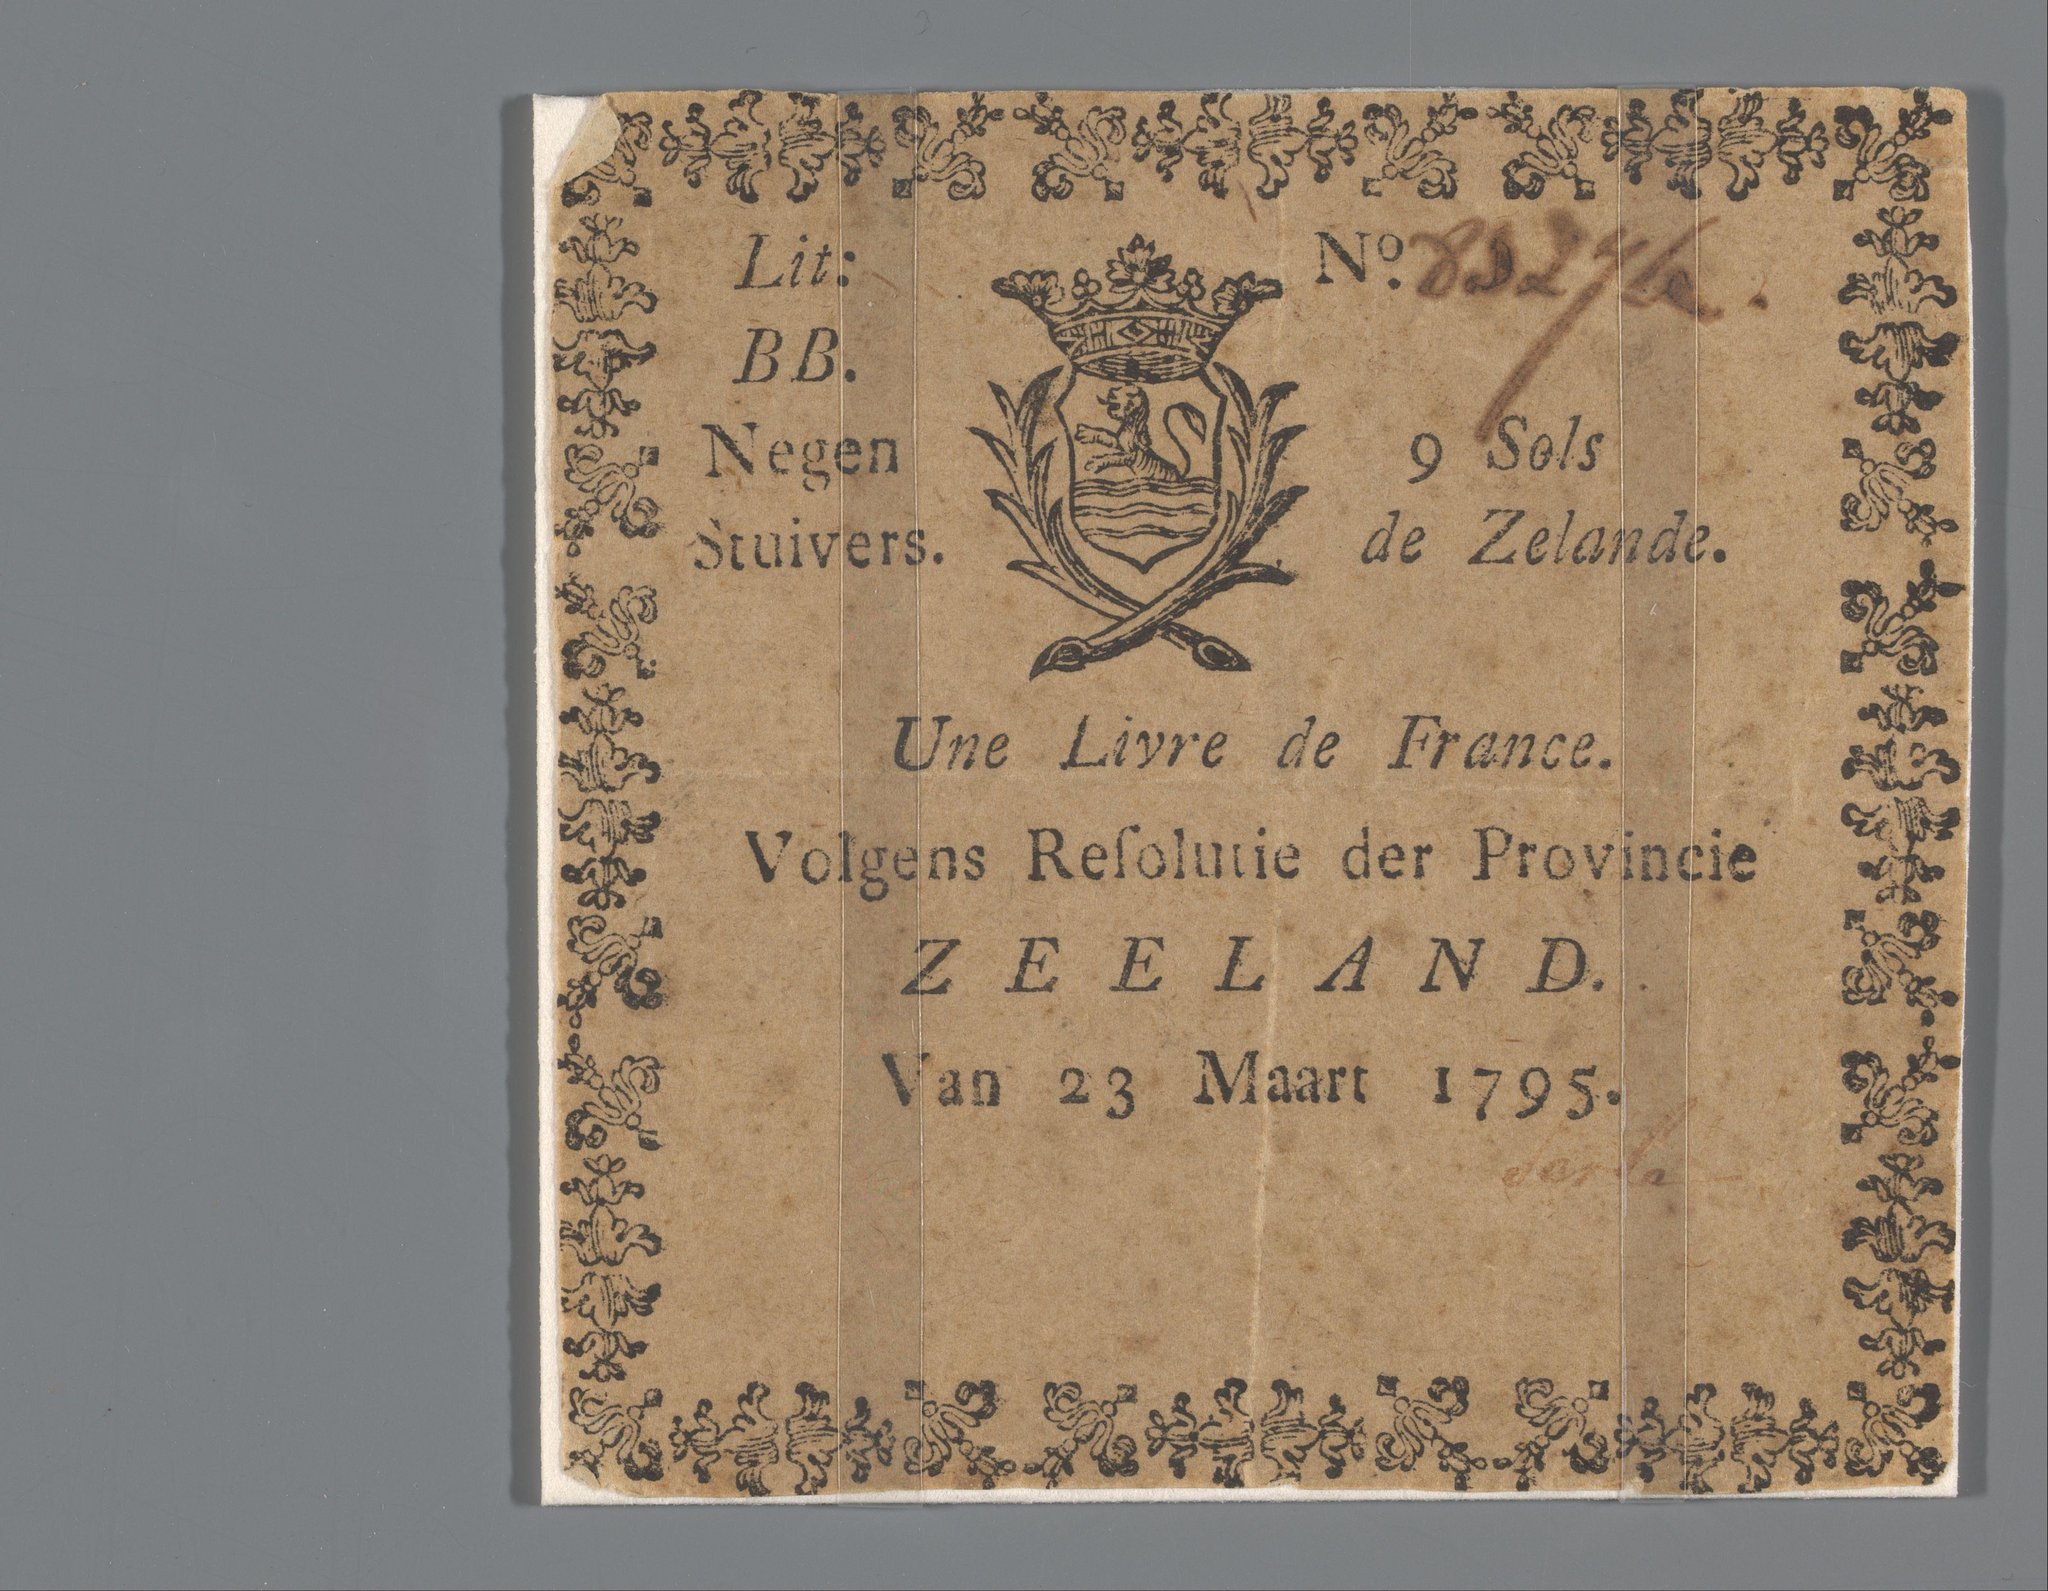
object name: assignat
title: Verovering der Nederlanden door de Fransen, assignaat uitgegeven door de provincie Zeeland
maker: Anonymous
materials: paper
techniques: printing, writing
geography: zeeland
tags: zeeland